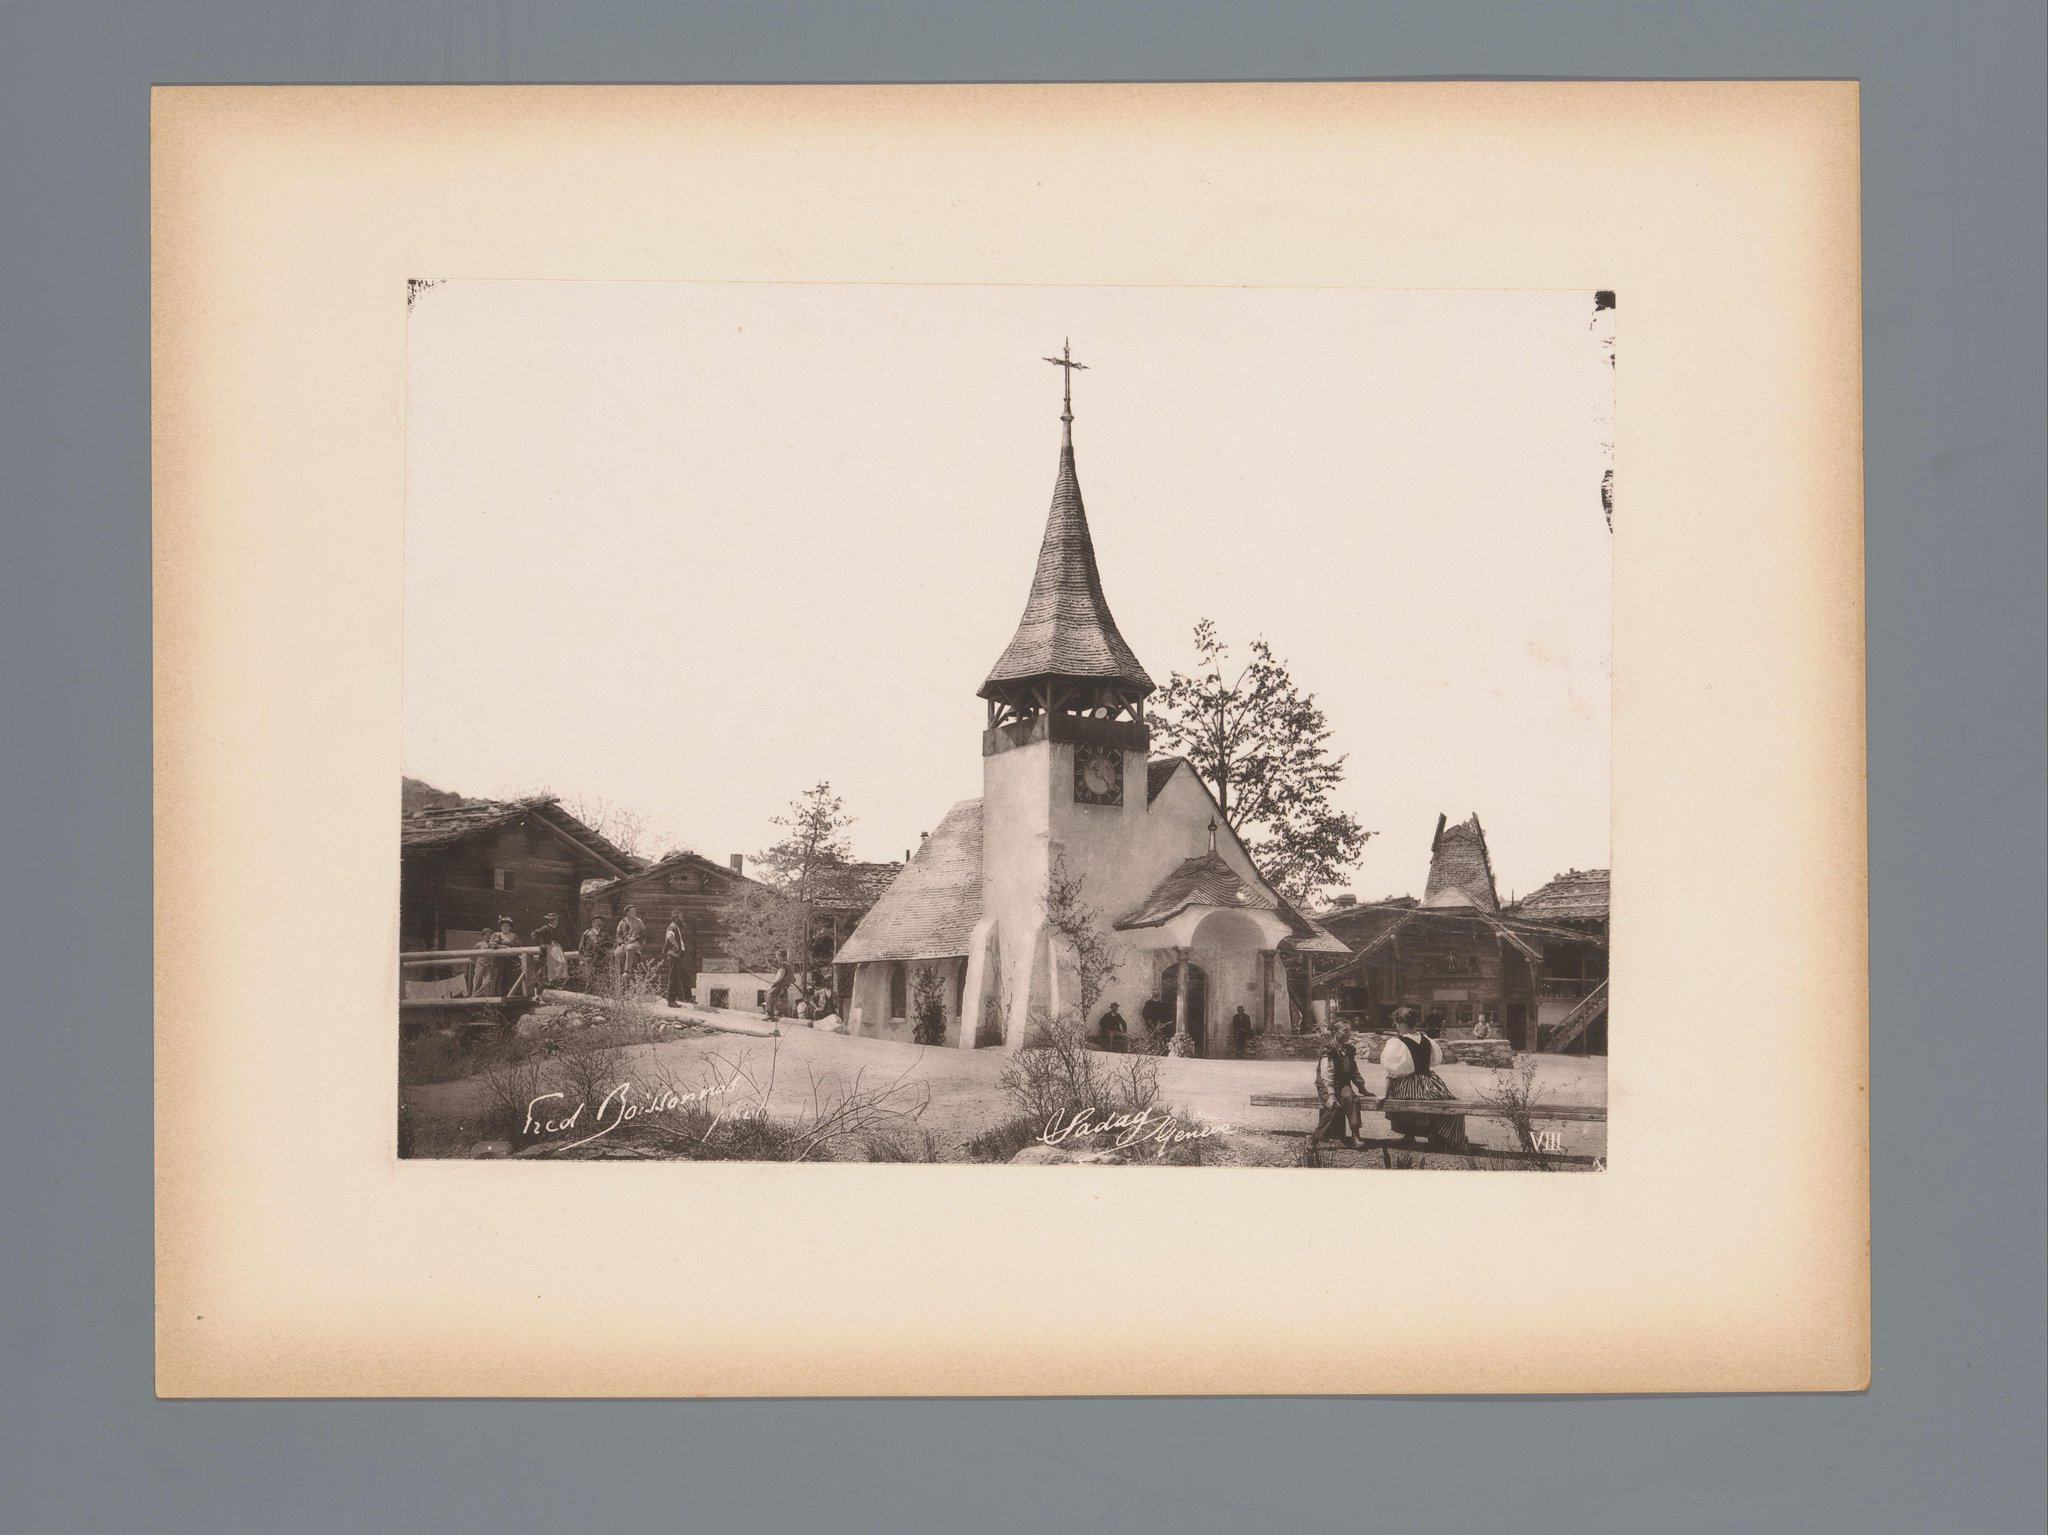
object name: page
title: Gezicht op een dorpsplein met kerk te Zwitserland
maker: frédéric boissonnas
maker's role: fotograaf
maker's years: 1858-1946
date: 1891-1896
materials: paper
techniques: photograph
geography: switzerland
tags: church (exterior), street (+ city(-scape) with figures, staffage), switzerland